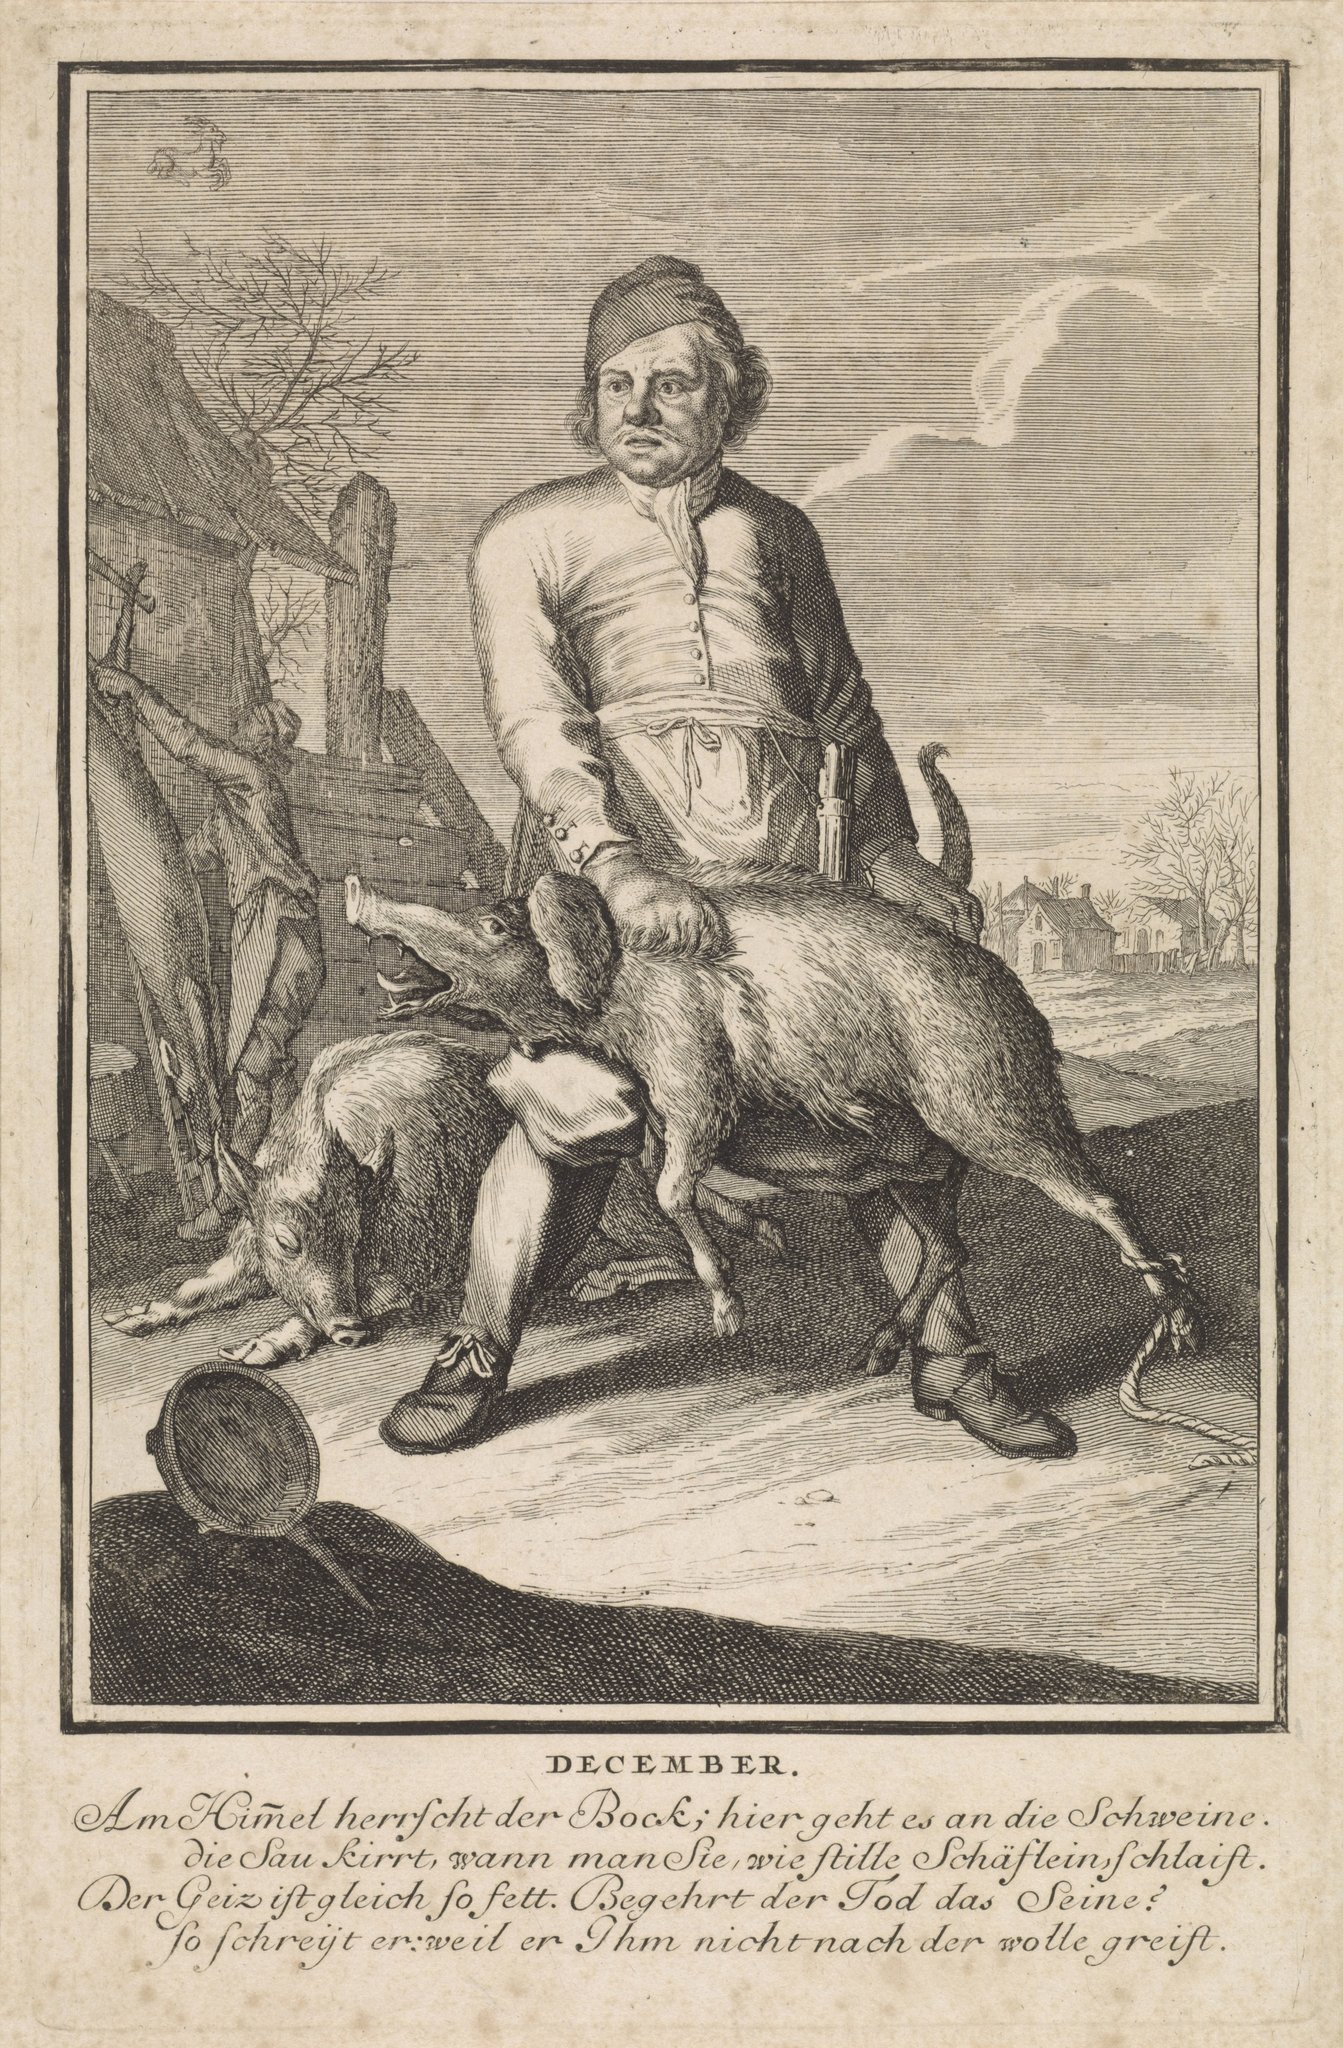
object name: print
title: De twaalf maanden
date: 1698-1702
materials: paper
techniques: engraving, etching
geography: nuremberg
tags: landscape symbolizing december, december; 'decembre' (ripa), december and its 'labours', slaughtered ox or pig, piglet, suckling pig, butcher, slaughterman, capricorn (zodiacal sign of december)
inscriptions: collector's mark: Lugt 2228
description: De maand december. Op de voorgrond een slager die een varken over zijn knie legt om het te slachten. Op de achtergrond wordt een varken opengesneden en opgehangen. De prent heeft een Duits onderschrift van vier regels over de maand december.